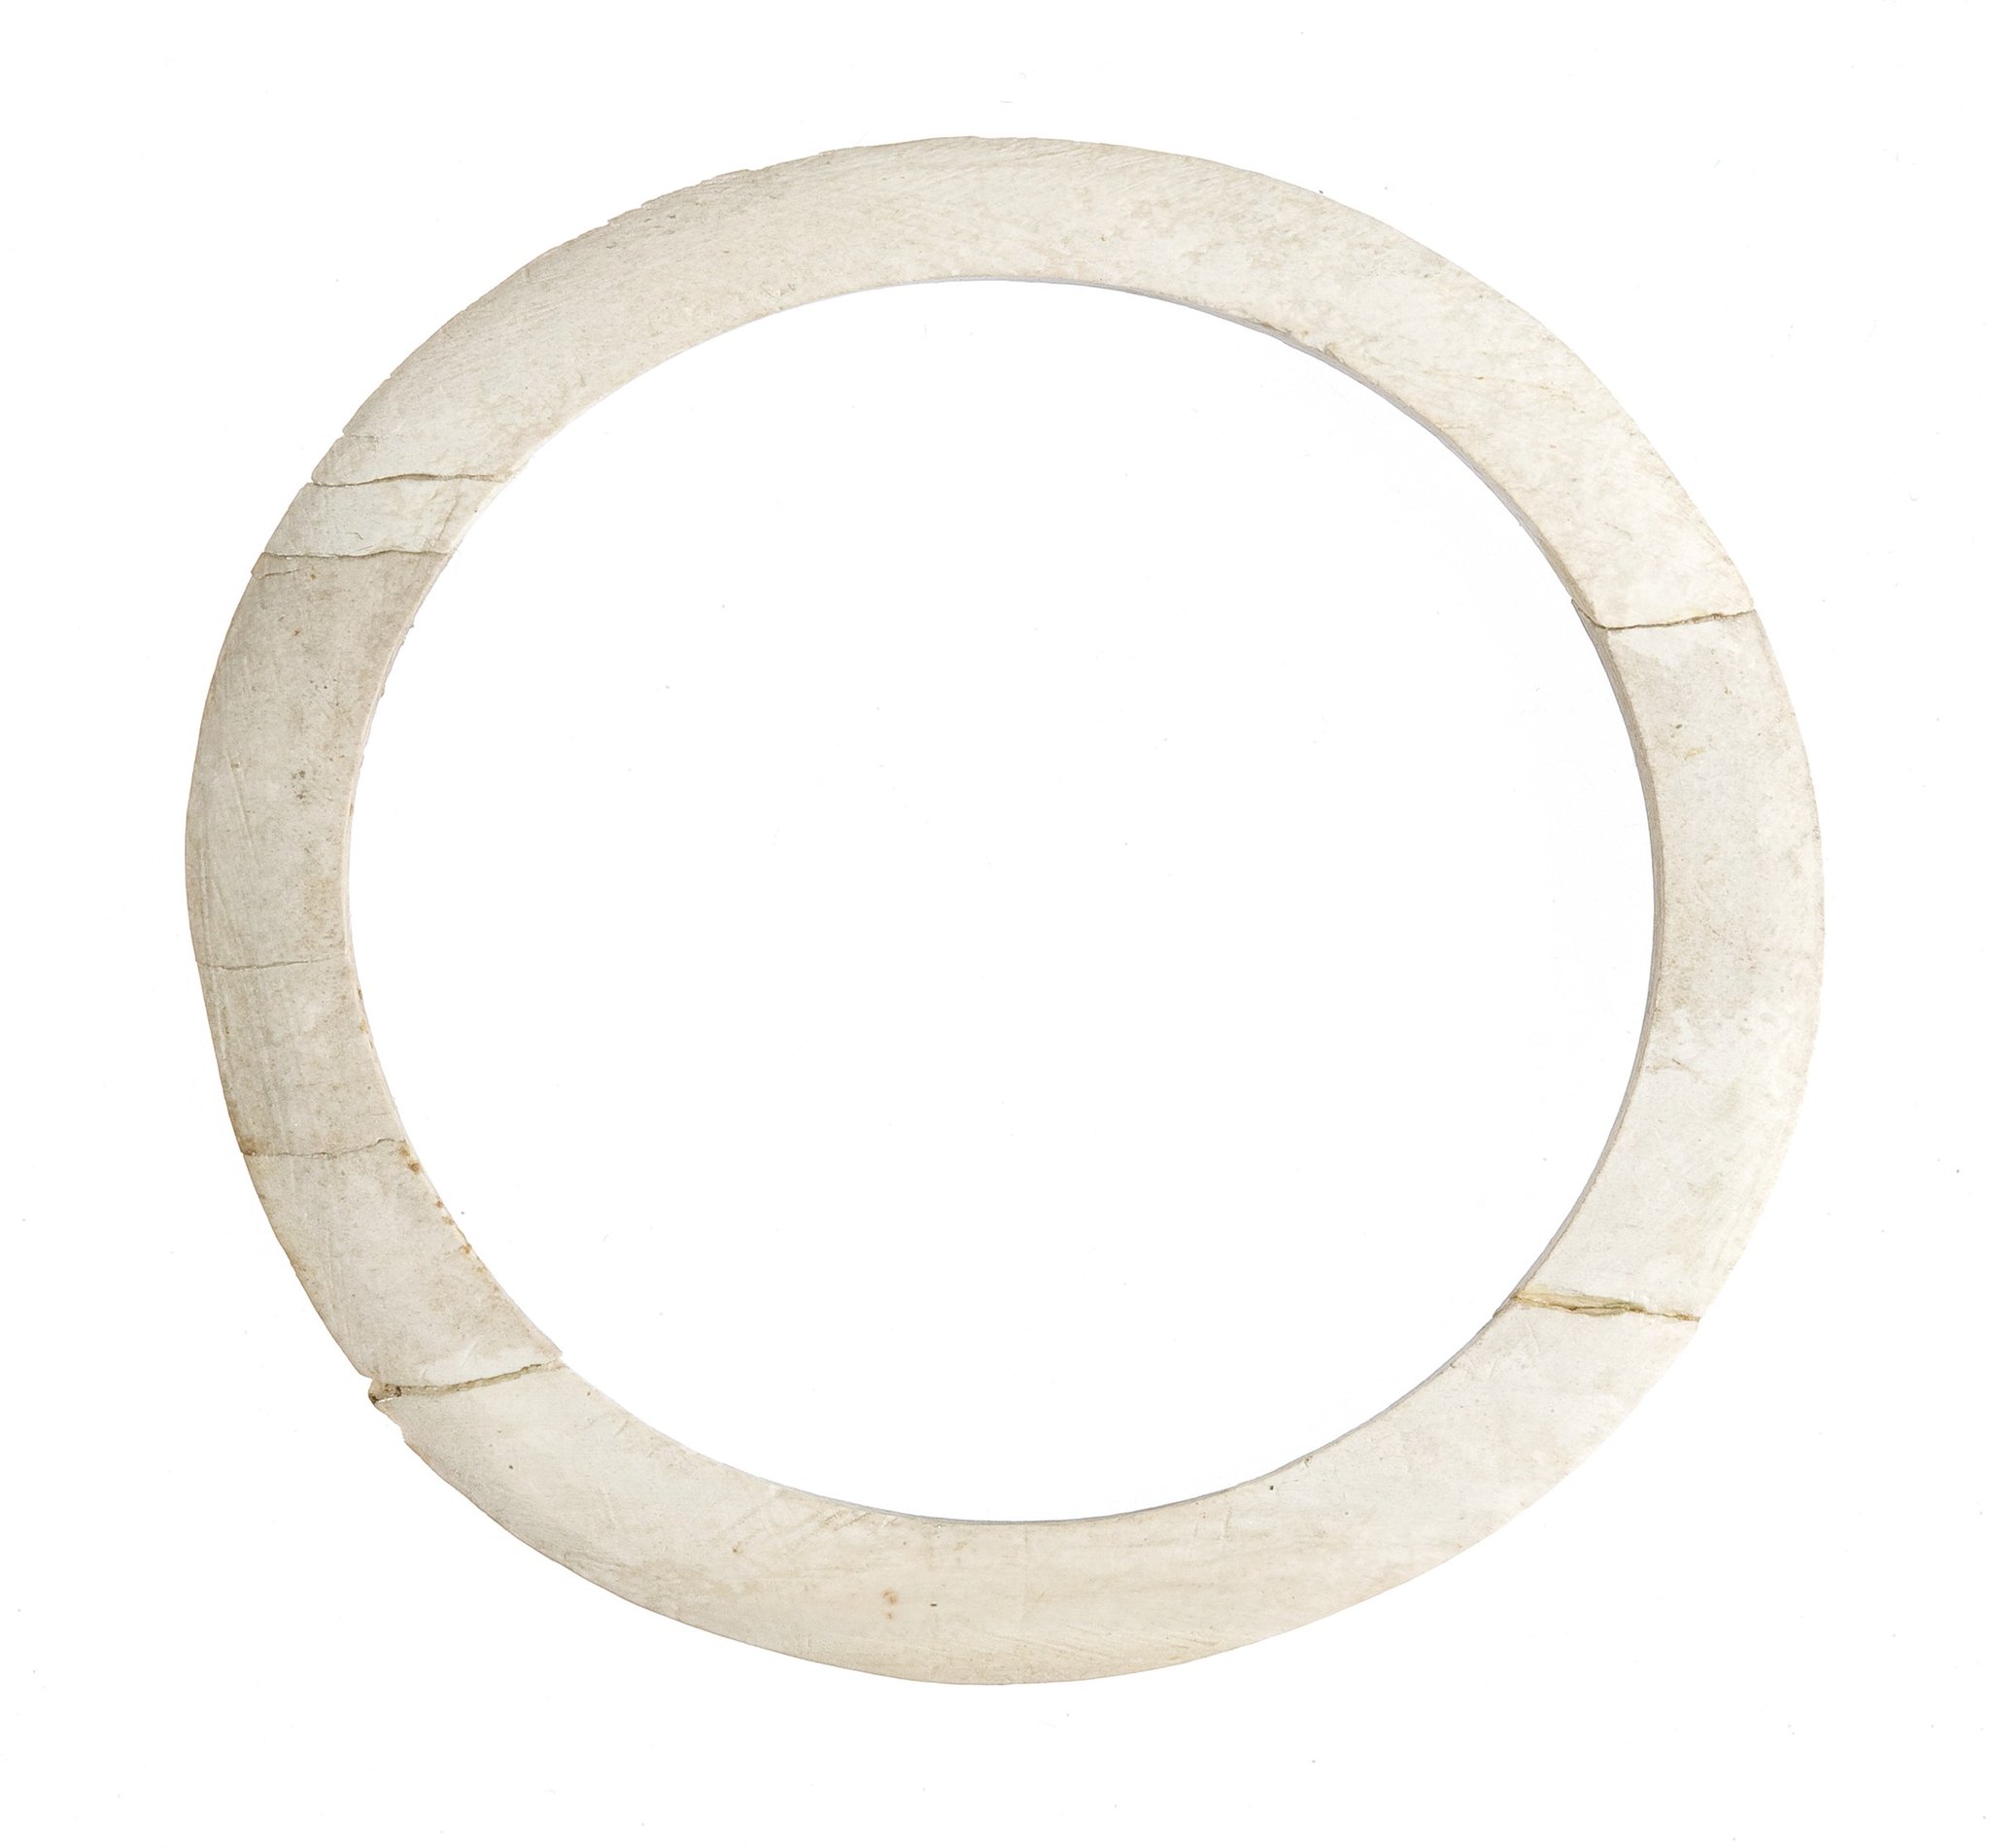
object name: bracelet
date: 1635-1458 BCE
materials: ivory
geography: egypt